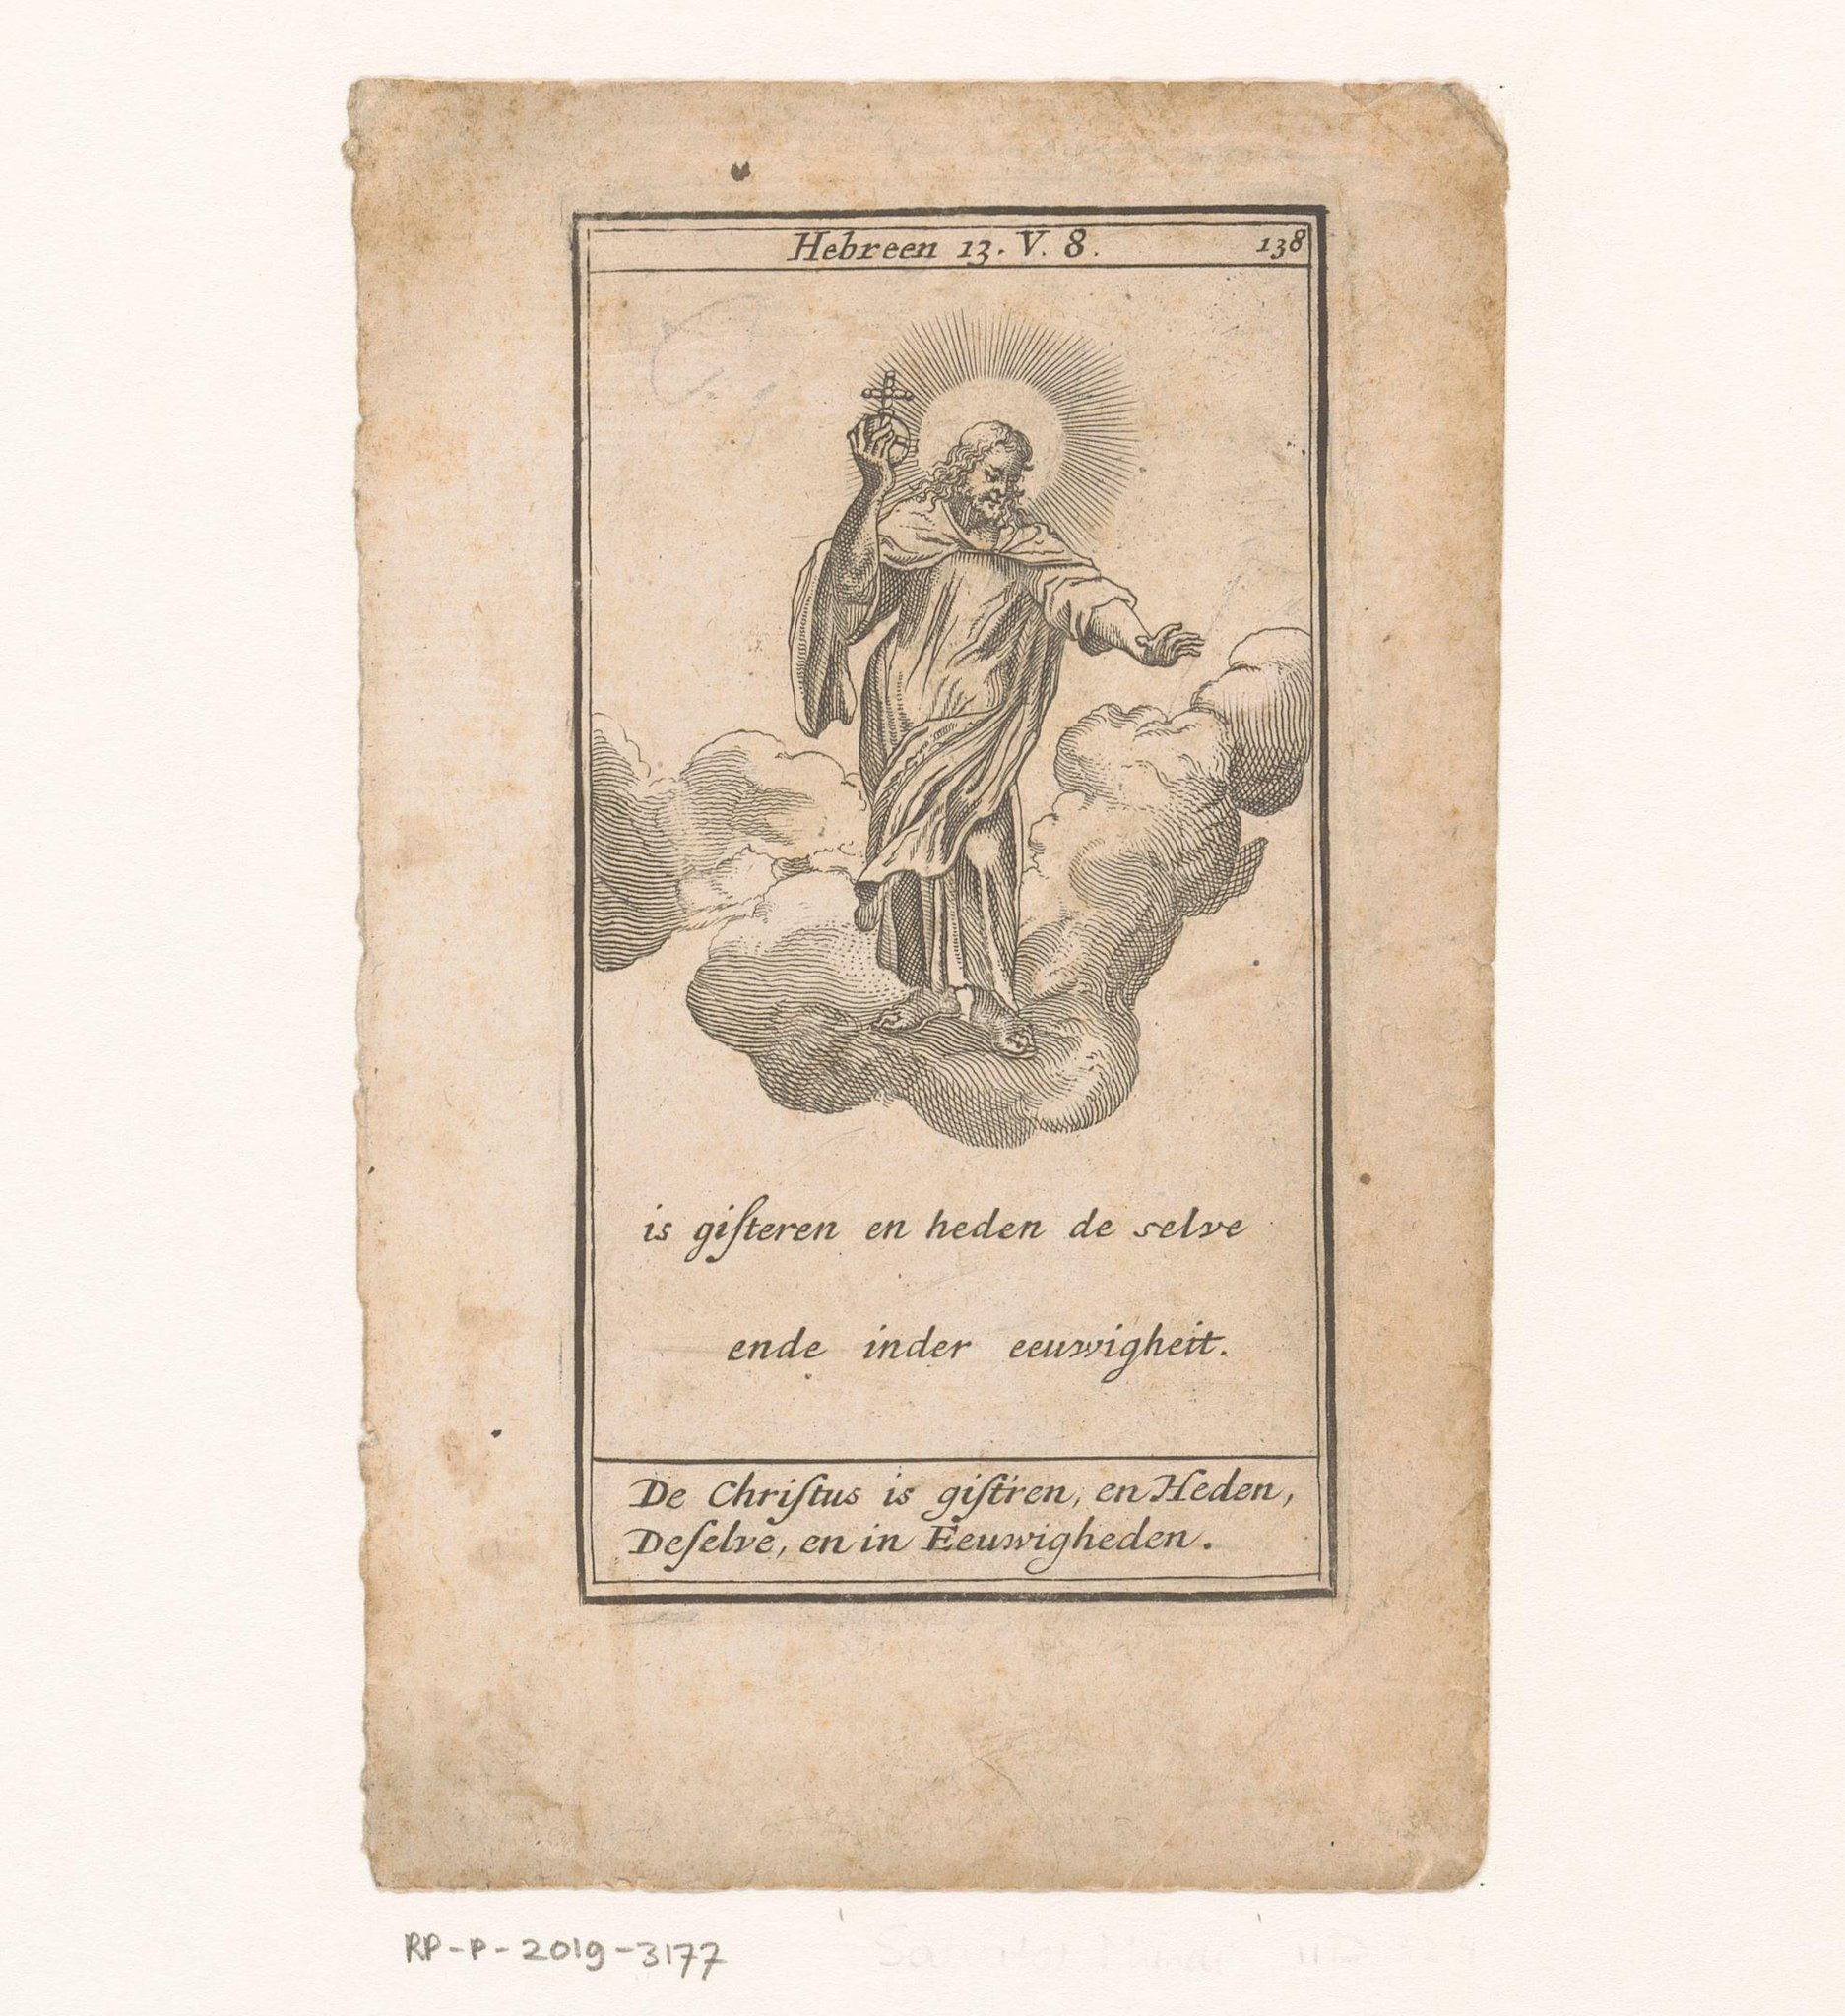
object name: print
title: Christus als Salvator Mundi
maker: Anonymous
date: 1700-1799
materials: paper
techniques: etching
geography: netherlands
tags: 'salvator mundi', making a blessing gesture; an orb in his hand or at his feet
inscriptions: collector's mark: Lugt 2228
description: Dit betreft waarschijnlijk een prent uit een onbekend boek.